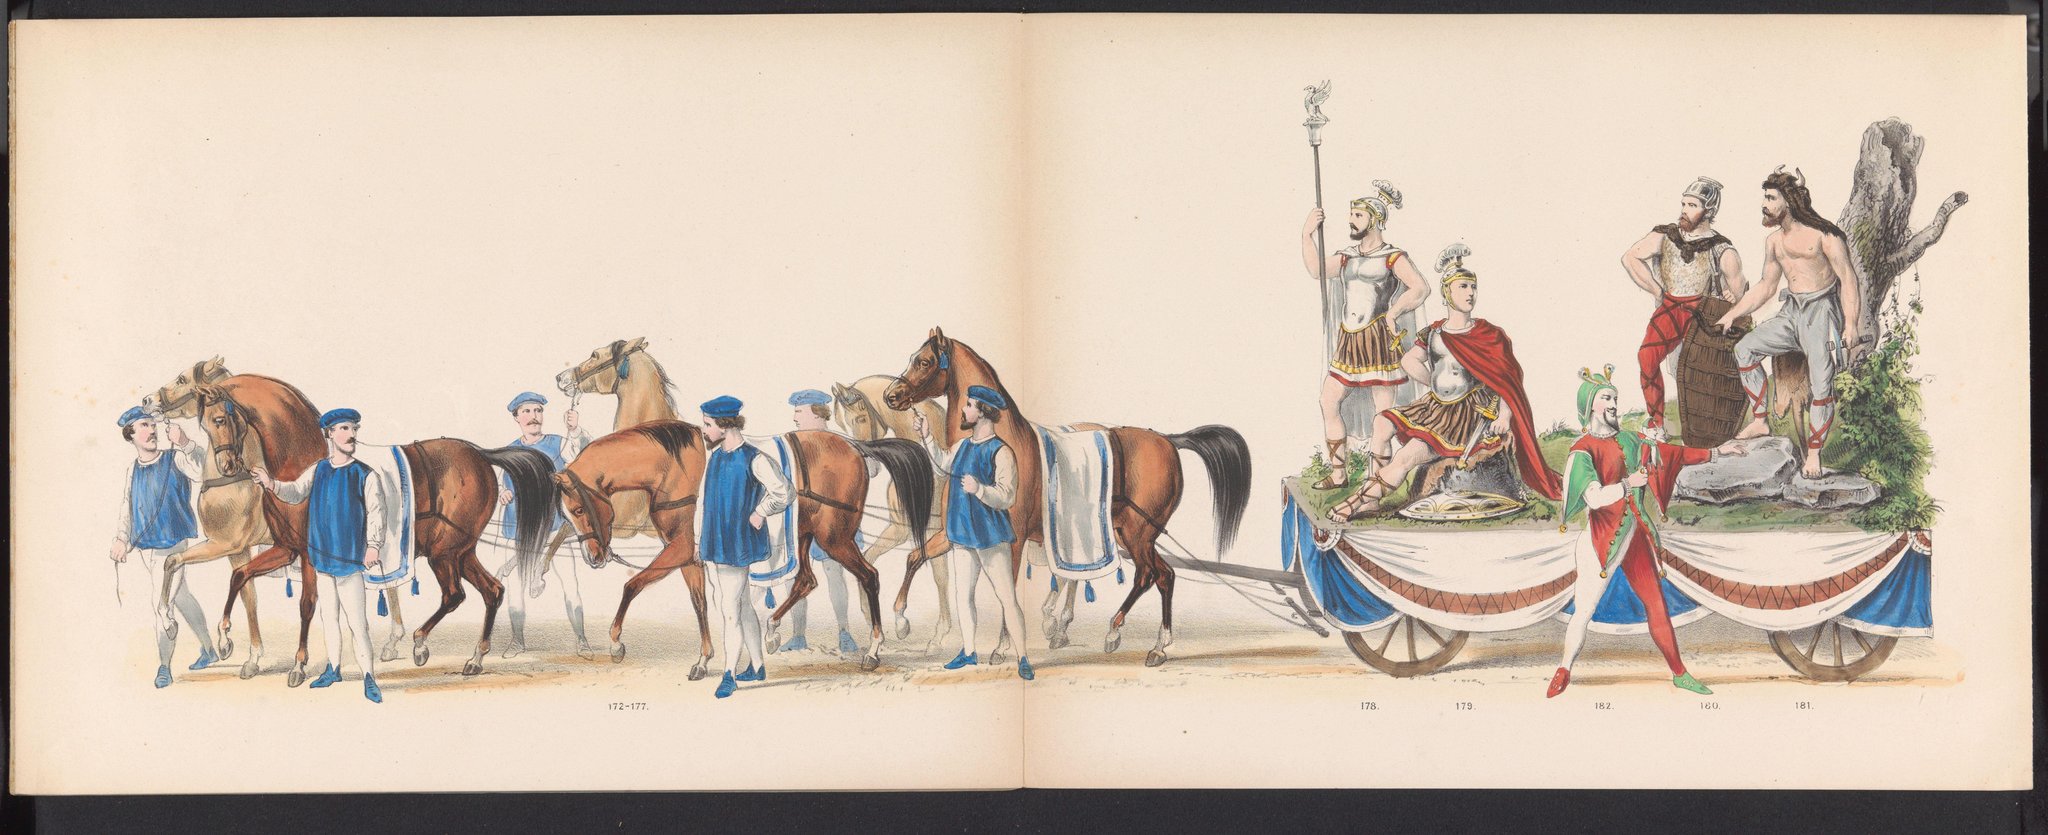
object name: print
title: Maskerade van de Leidse studenten, 1870 (plaat 15)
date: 1870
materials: paper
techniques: hand coloring, lithograph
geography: netherlands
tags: robert dudley (1st earl of leicester), students' pageant, costumes used in pageants, leiden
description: Historische gekostumeerde optocht van de studenten van de Leidse Hogeschool gehouden op 7 juni 1870 ter gelegenheid van het 295-jarig bestaan van de Hogeschool. De optocht verbeeldt de intocht van de Graaf van Leicester in Leiden in 1586. Vijftiende plaat met de groepen genummerd 172-181. Onderdeel van de serie van 18 aaneen geplakte bladen.